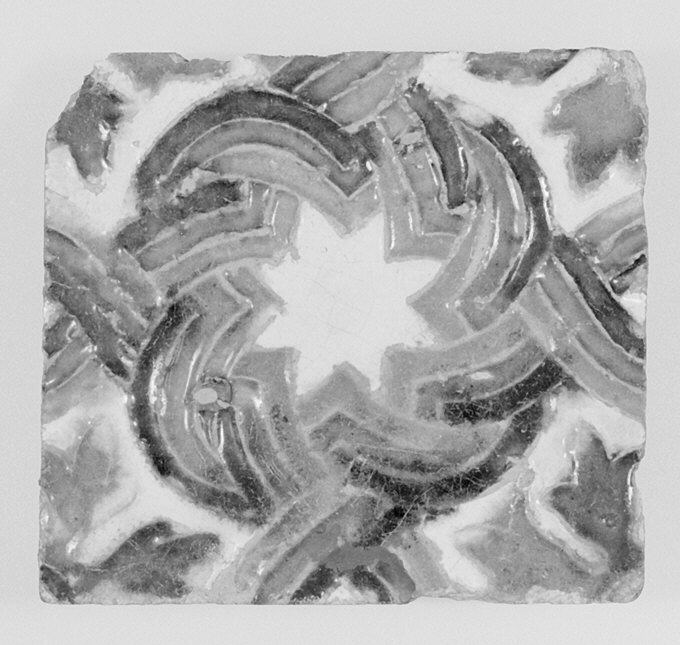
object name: wall tile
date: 1501-1600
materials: earthenware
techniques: glazing